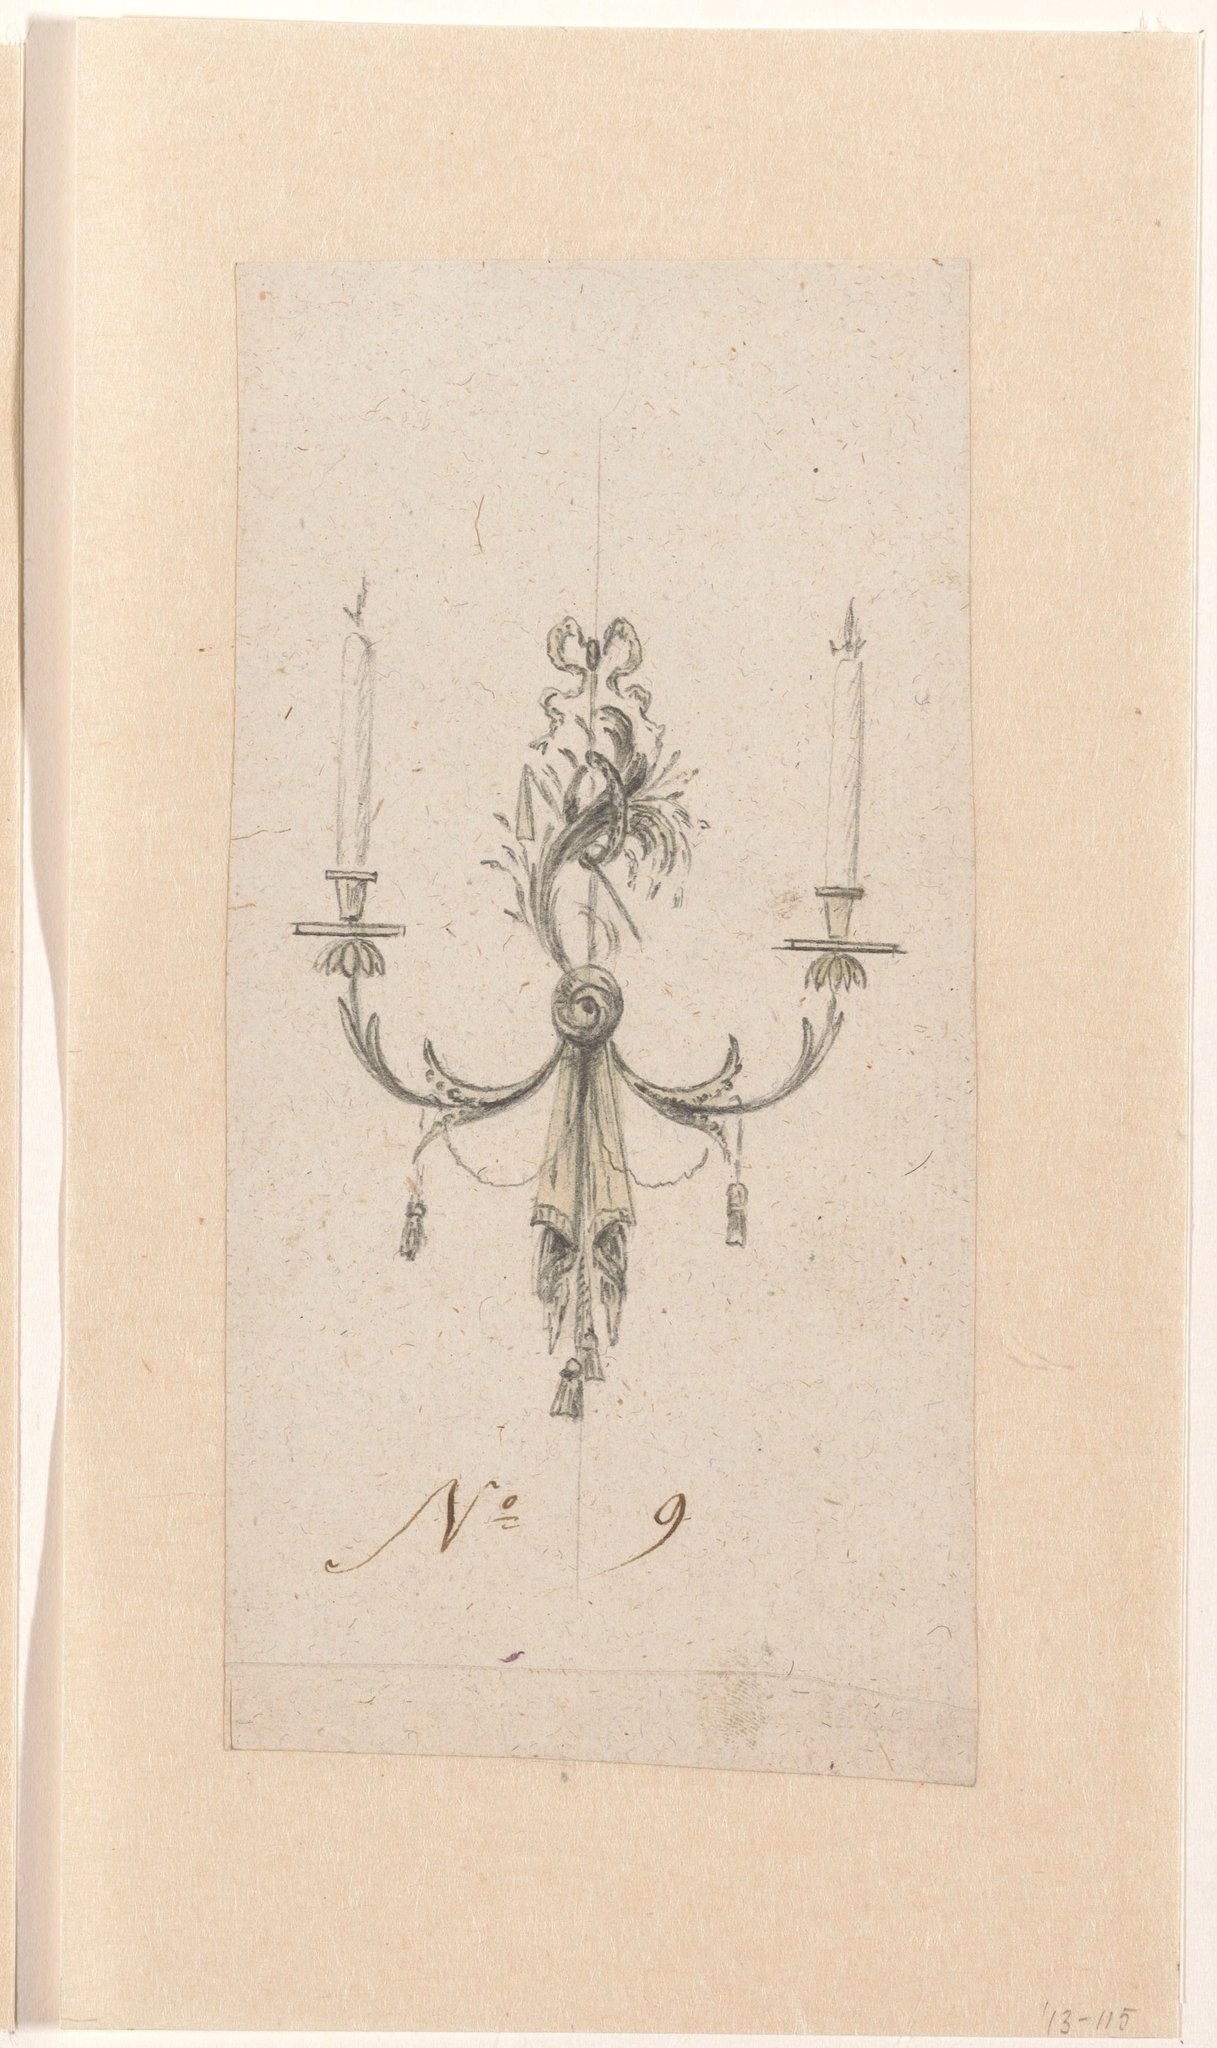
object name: drawing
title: Ontwerp voor een kandelaar (No. 9)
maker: abraham meertens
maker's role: draughtsman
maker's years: 1757-1823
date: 1767-1823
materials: paper, pencil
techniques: brush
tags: sconce, wall lamp